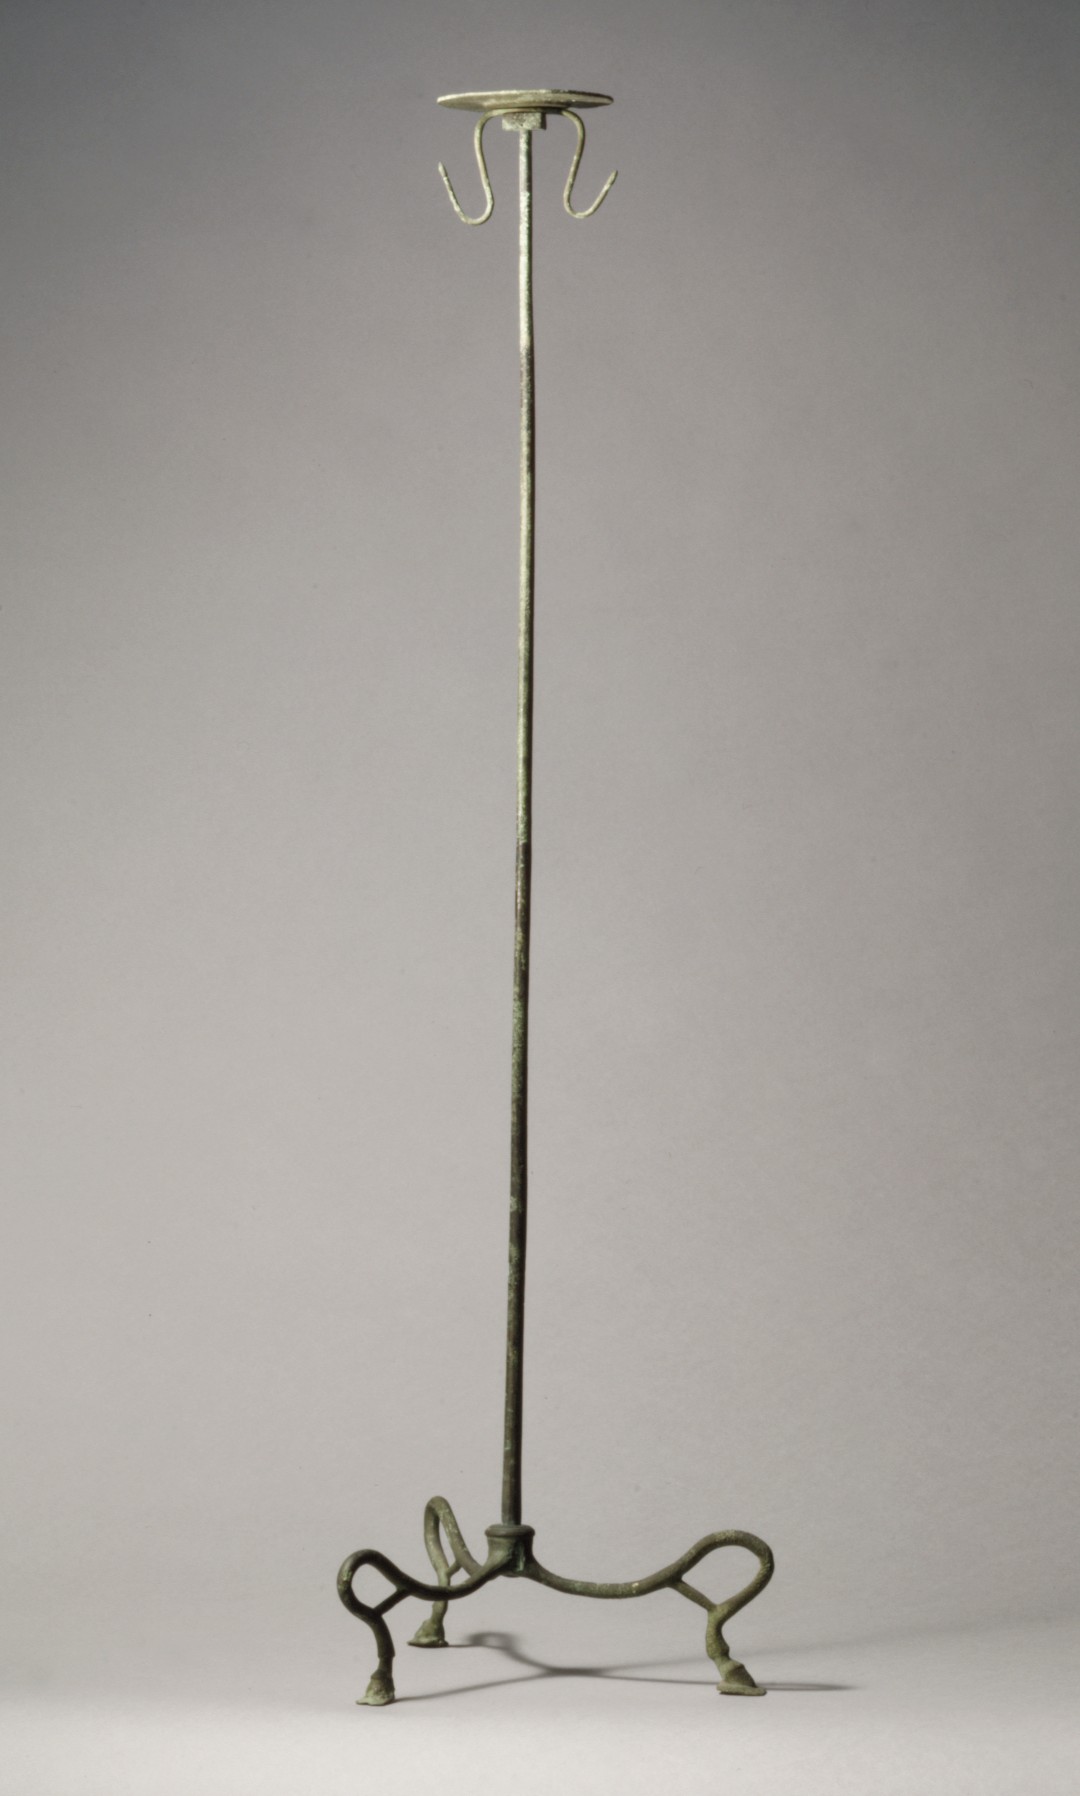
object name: lampstand with hoof foot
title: Bronze lampstand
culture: cypriot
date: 534-501 BCE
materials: bronze